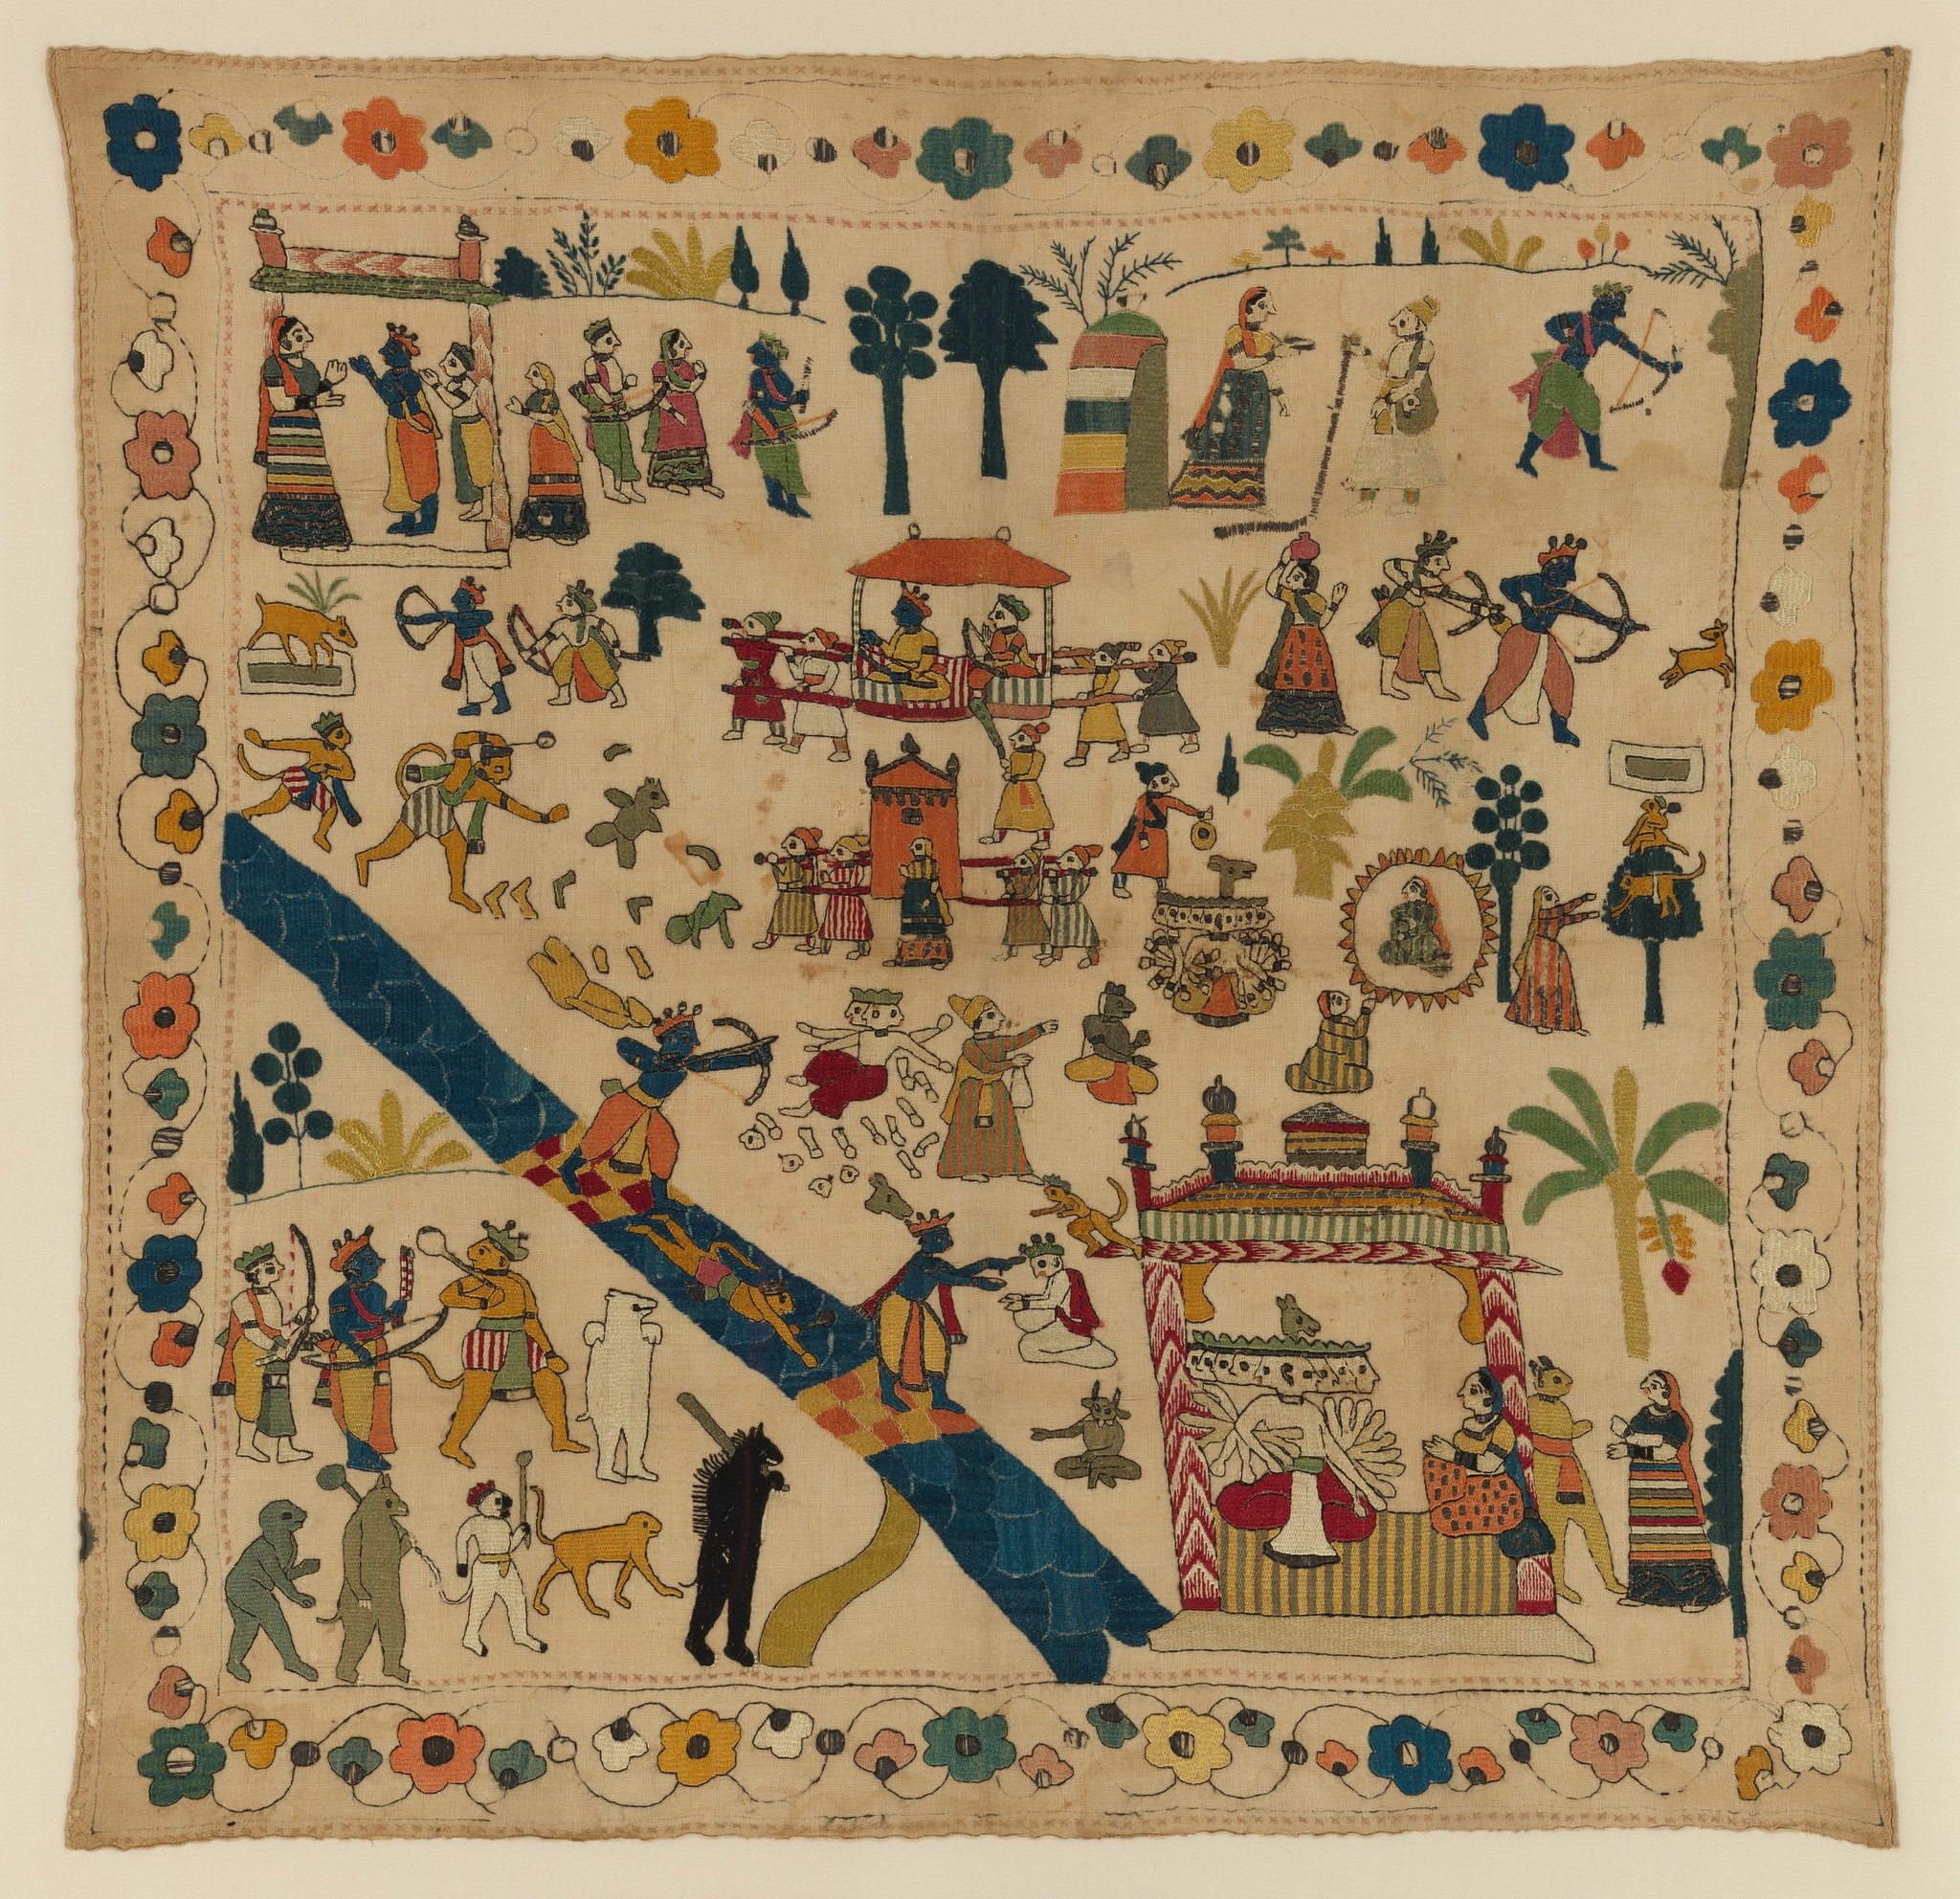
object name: cover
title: Rumal with Scenes from the Ramayana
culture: indian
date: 1701-1800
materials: cotton, metal, silk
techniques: embroidery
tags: bears,bow and arrow,men,women,monkeys,vishnu